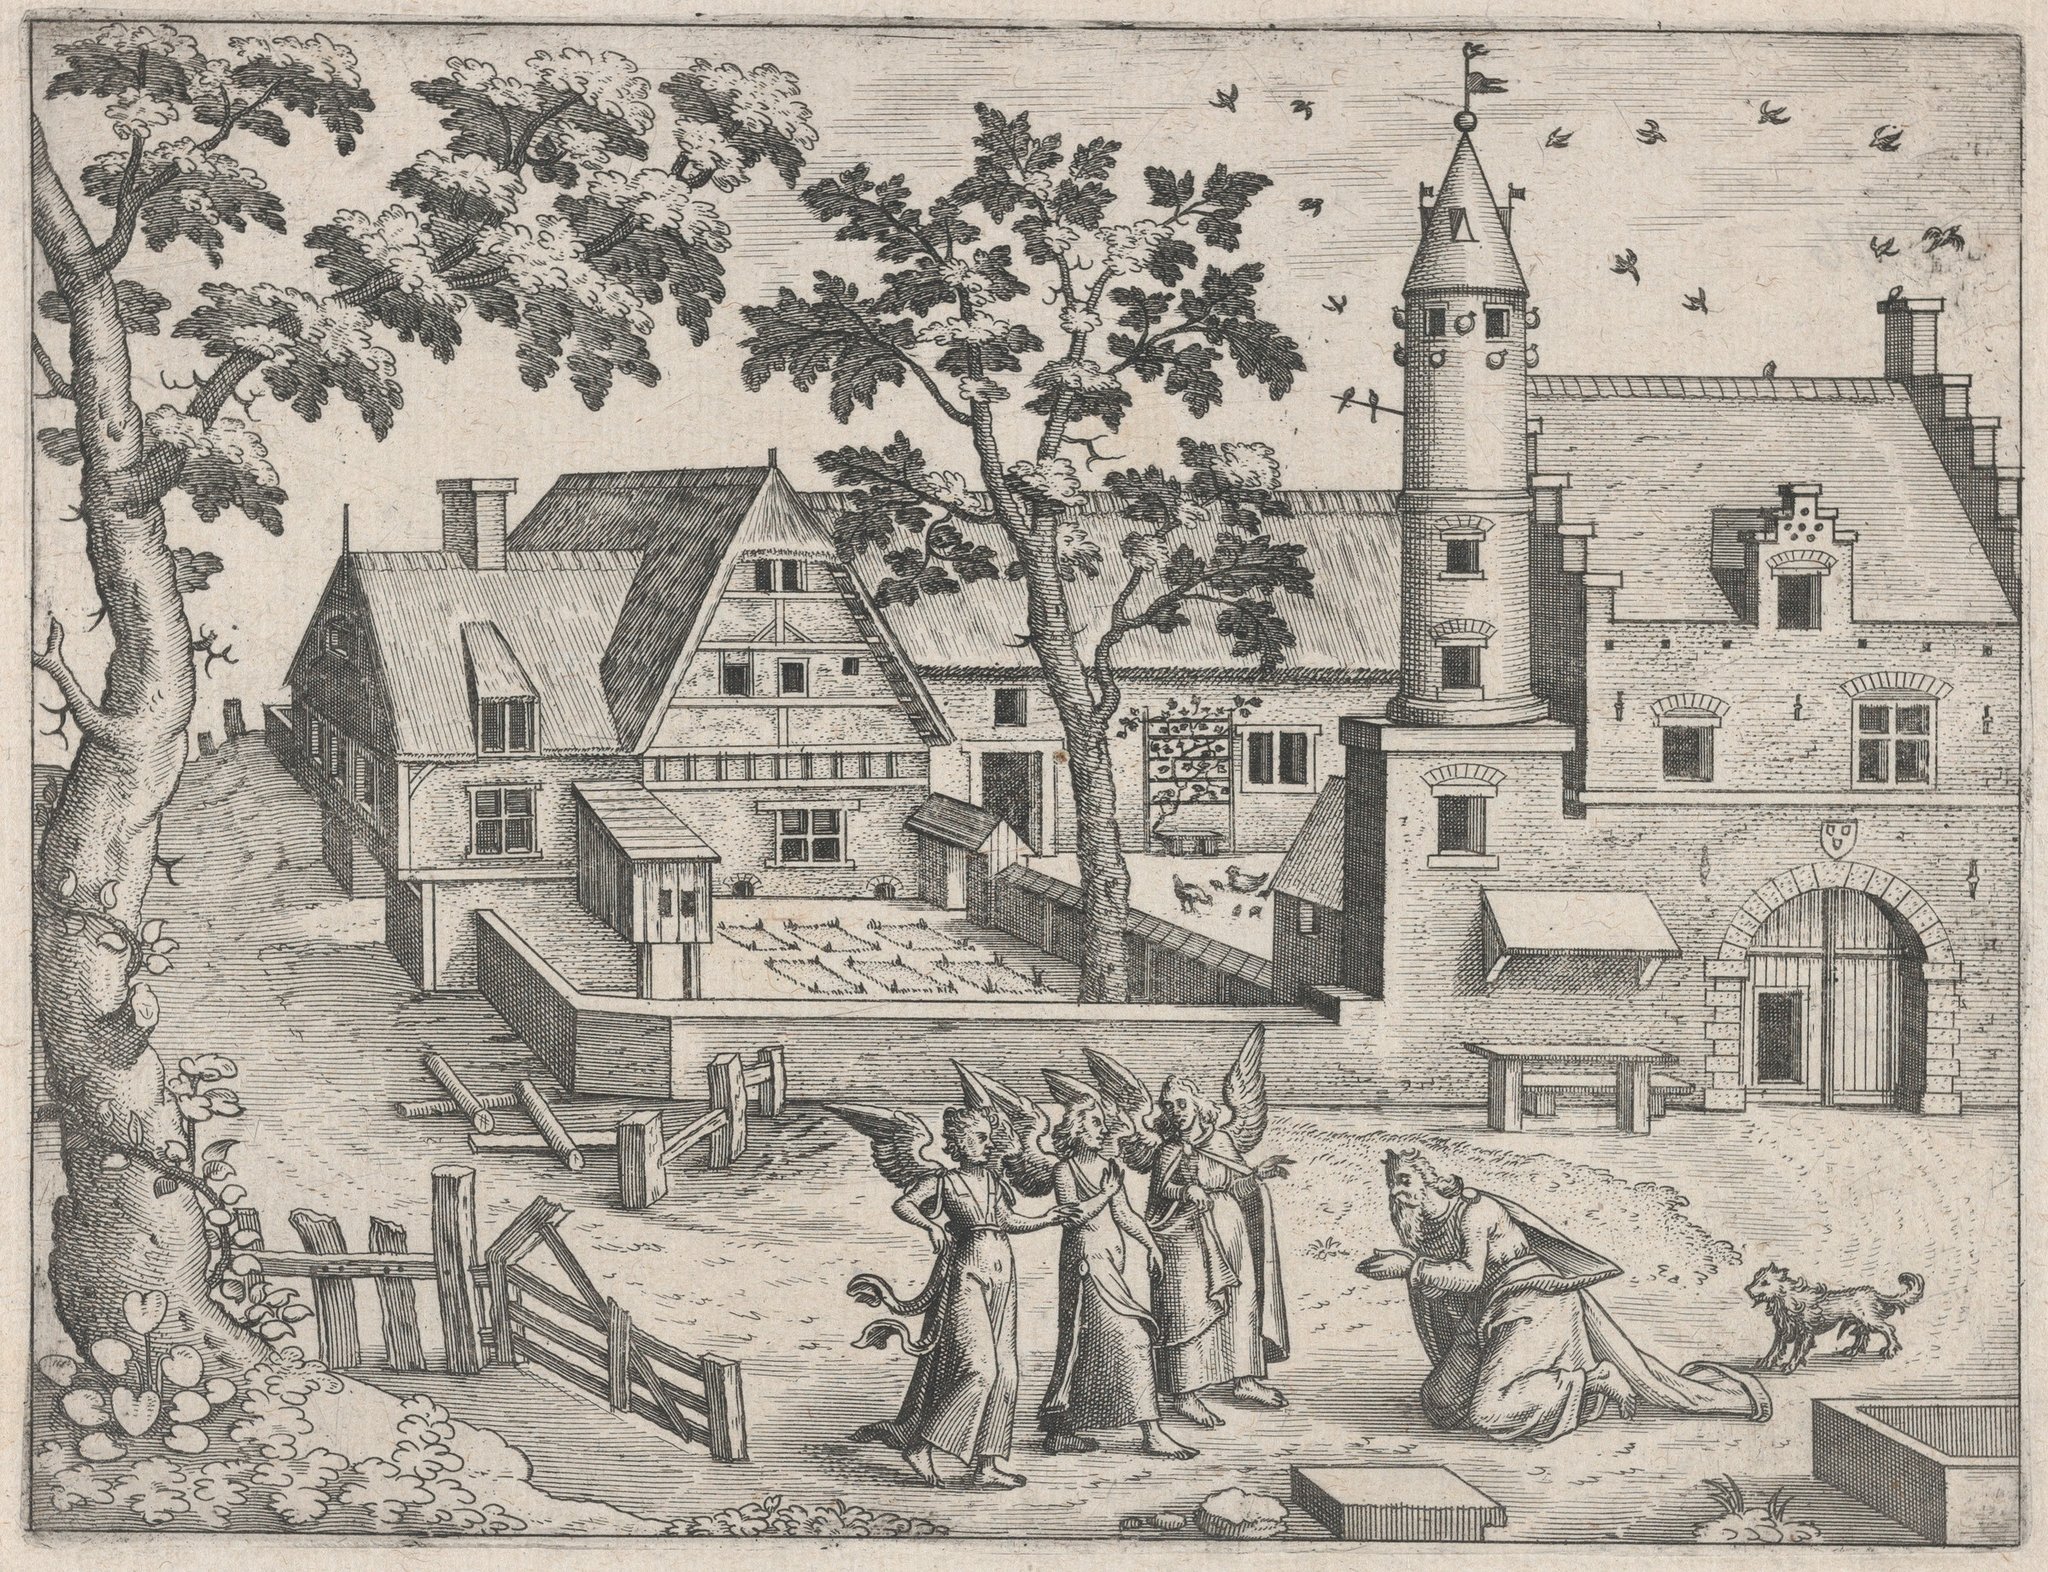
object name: print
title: Landscape with Abraham and Three Angels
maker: lucas gassel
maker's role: artist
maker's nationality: netherlandish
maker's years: 1495-1500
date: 1560-1570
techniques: engraving, etching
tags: houses,landscapes,trees,angels,abraham